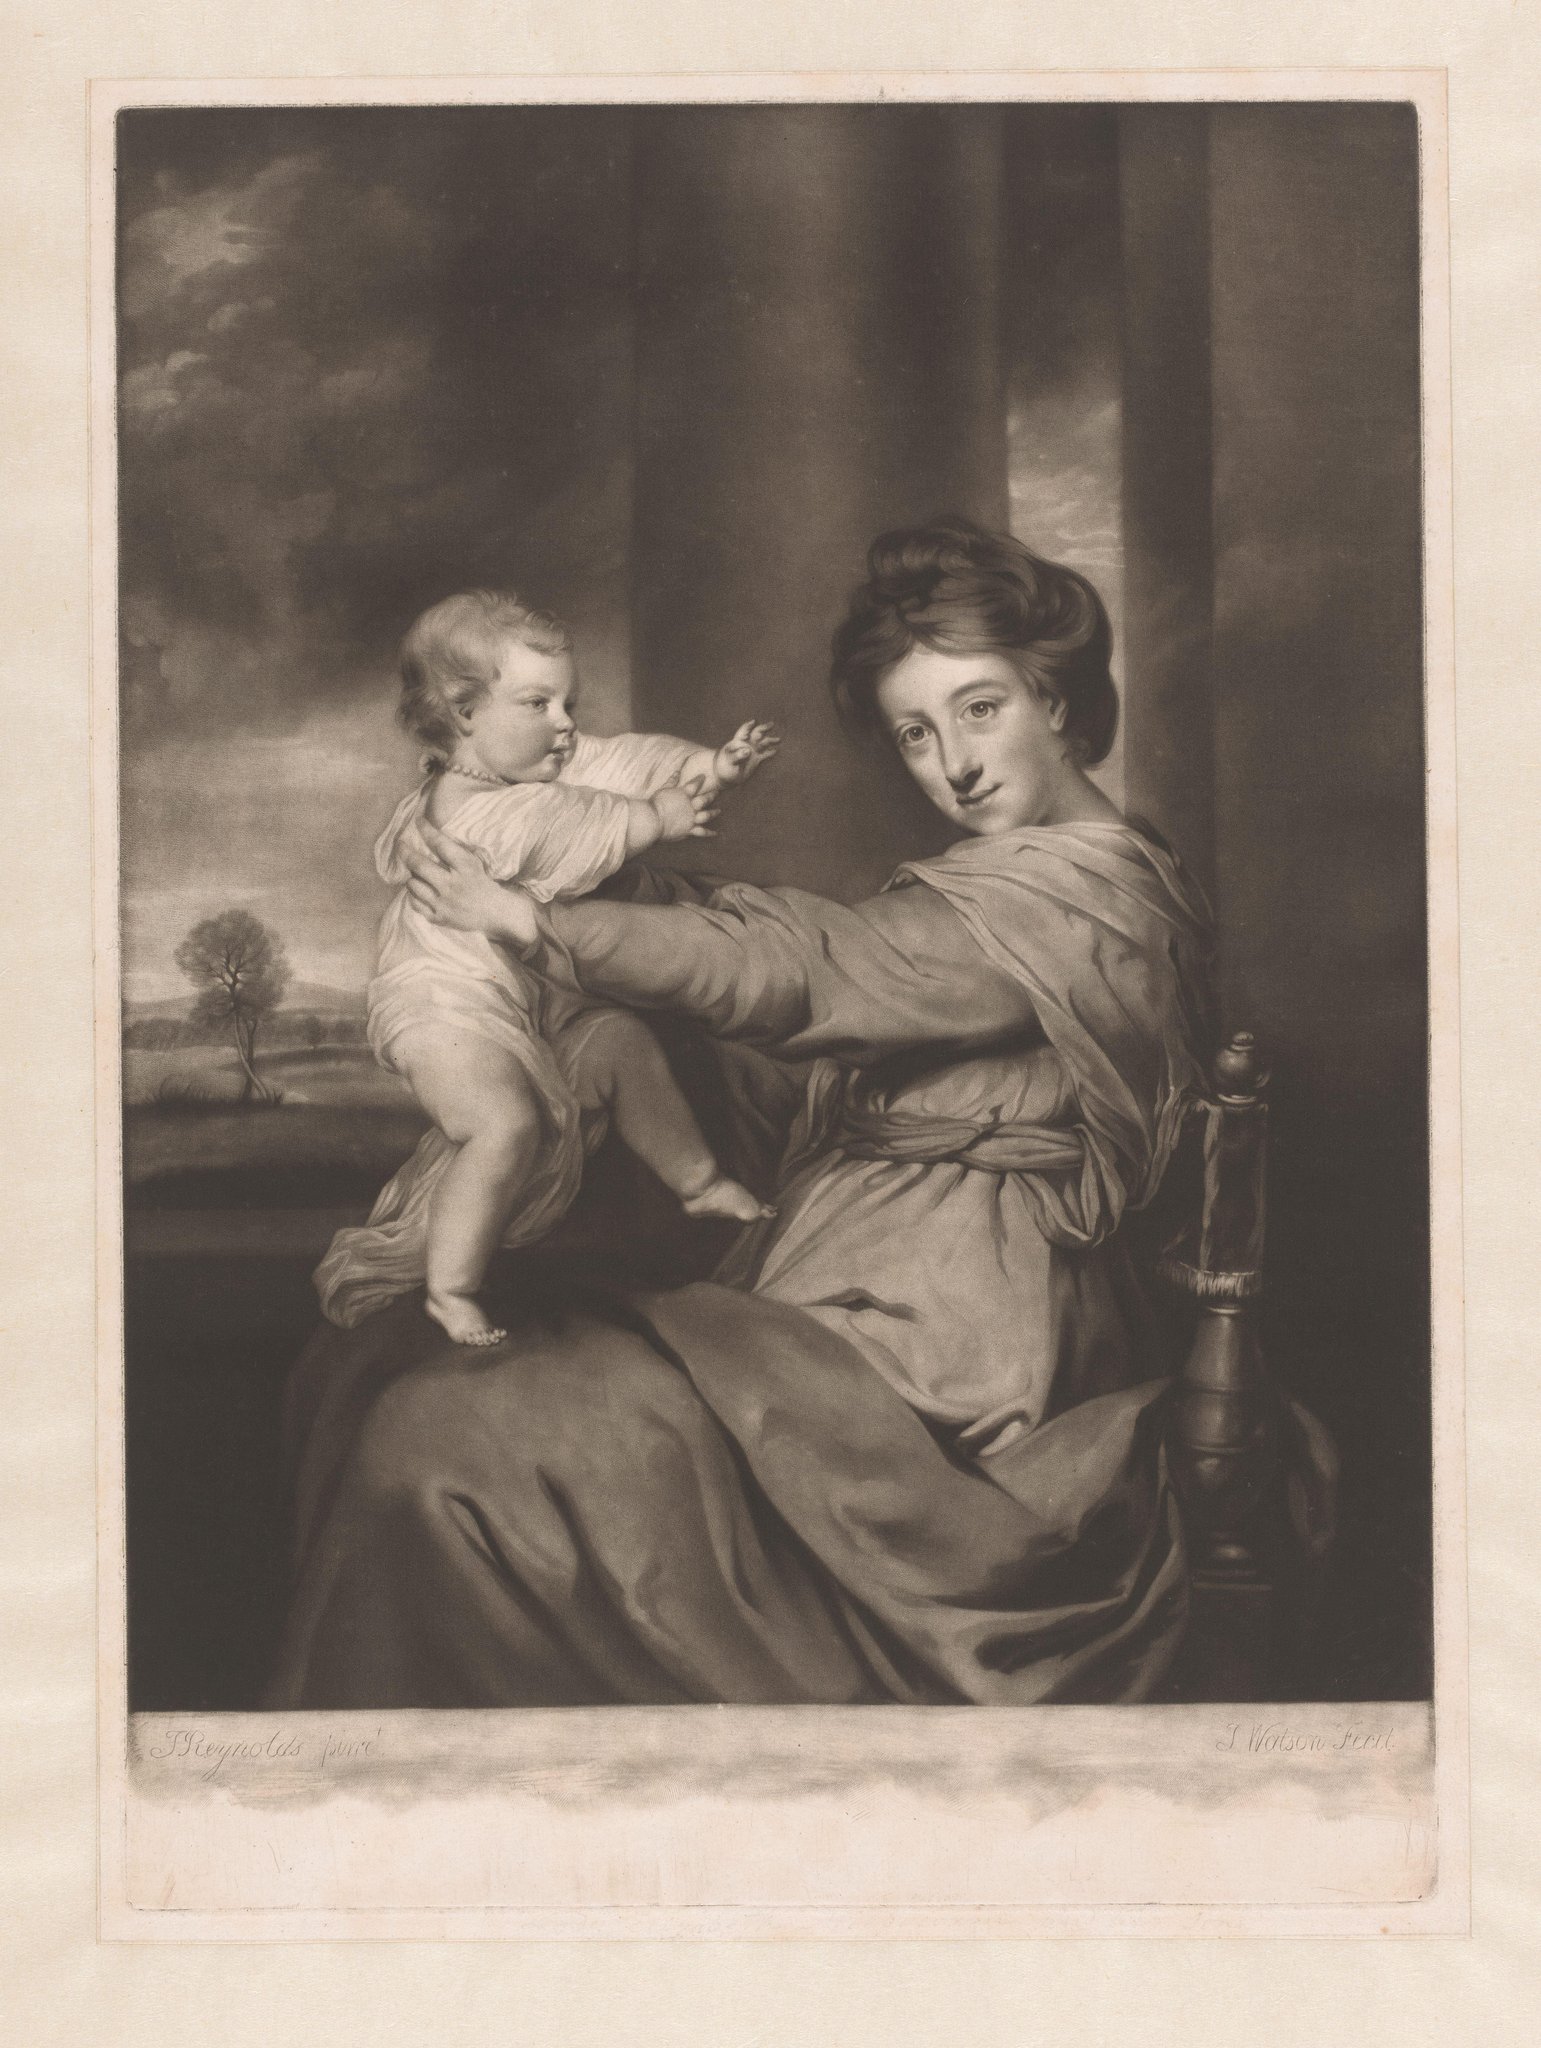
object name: print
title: Portret van Caroline Spencer met haar dochter Caroline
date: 1768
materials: paper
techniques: mezzotint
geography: london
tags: historical persons - bb - woman, mother and baby or young child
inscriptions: collector's mark: Lugt 240